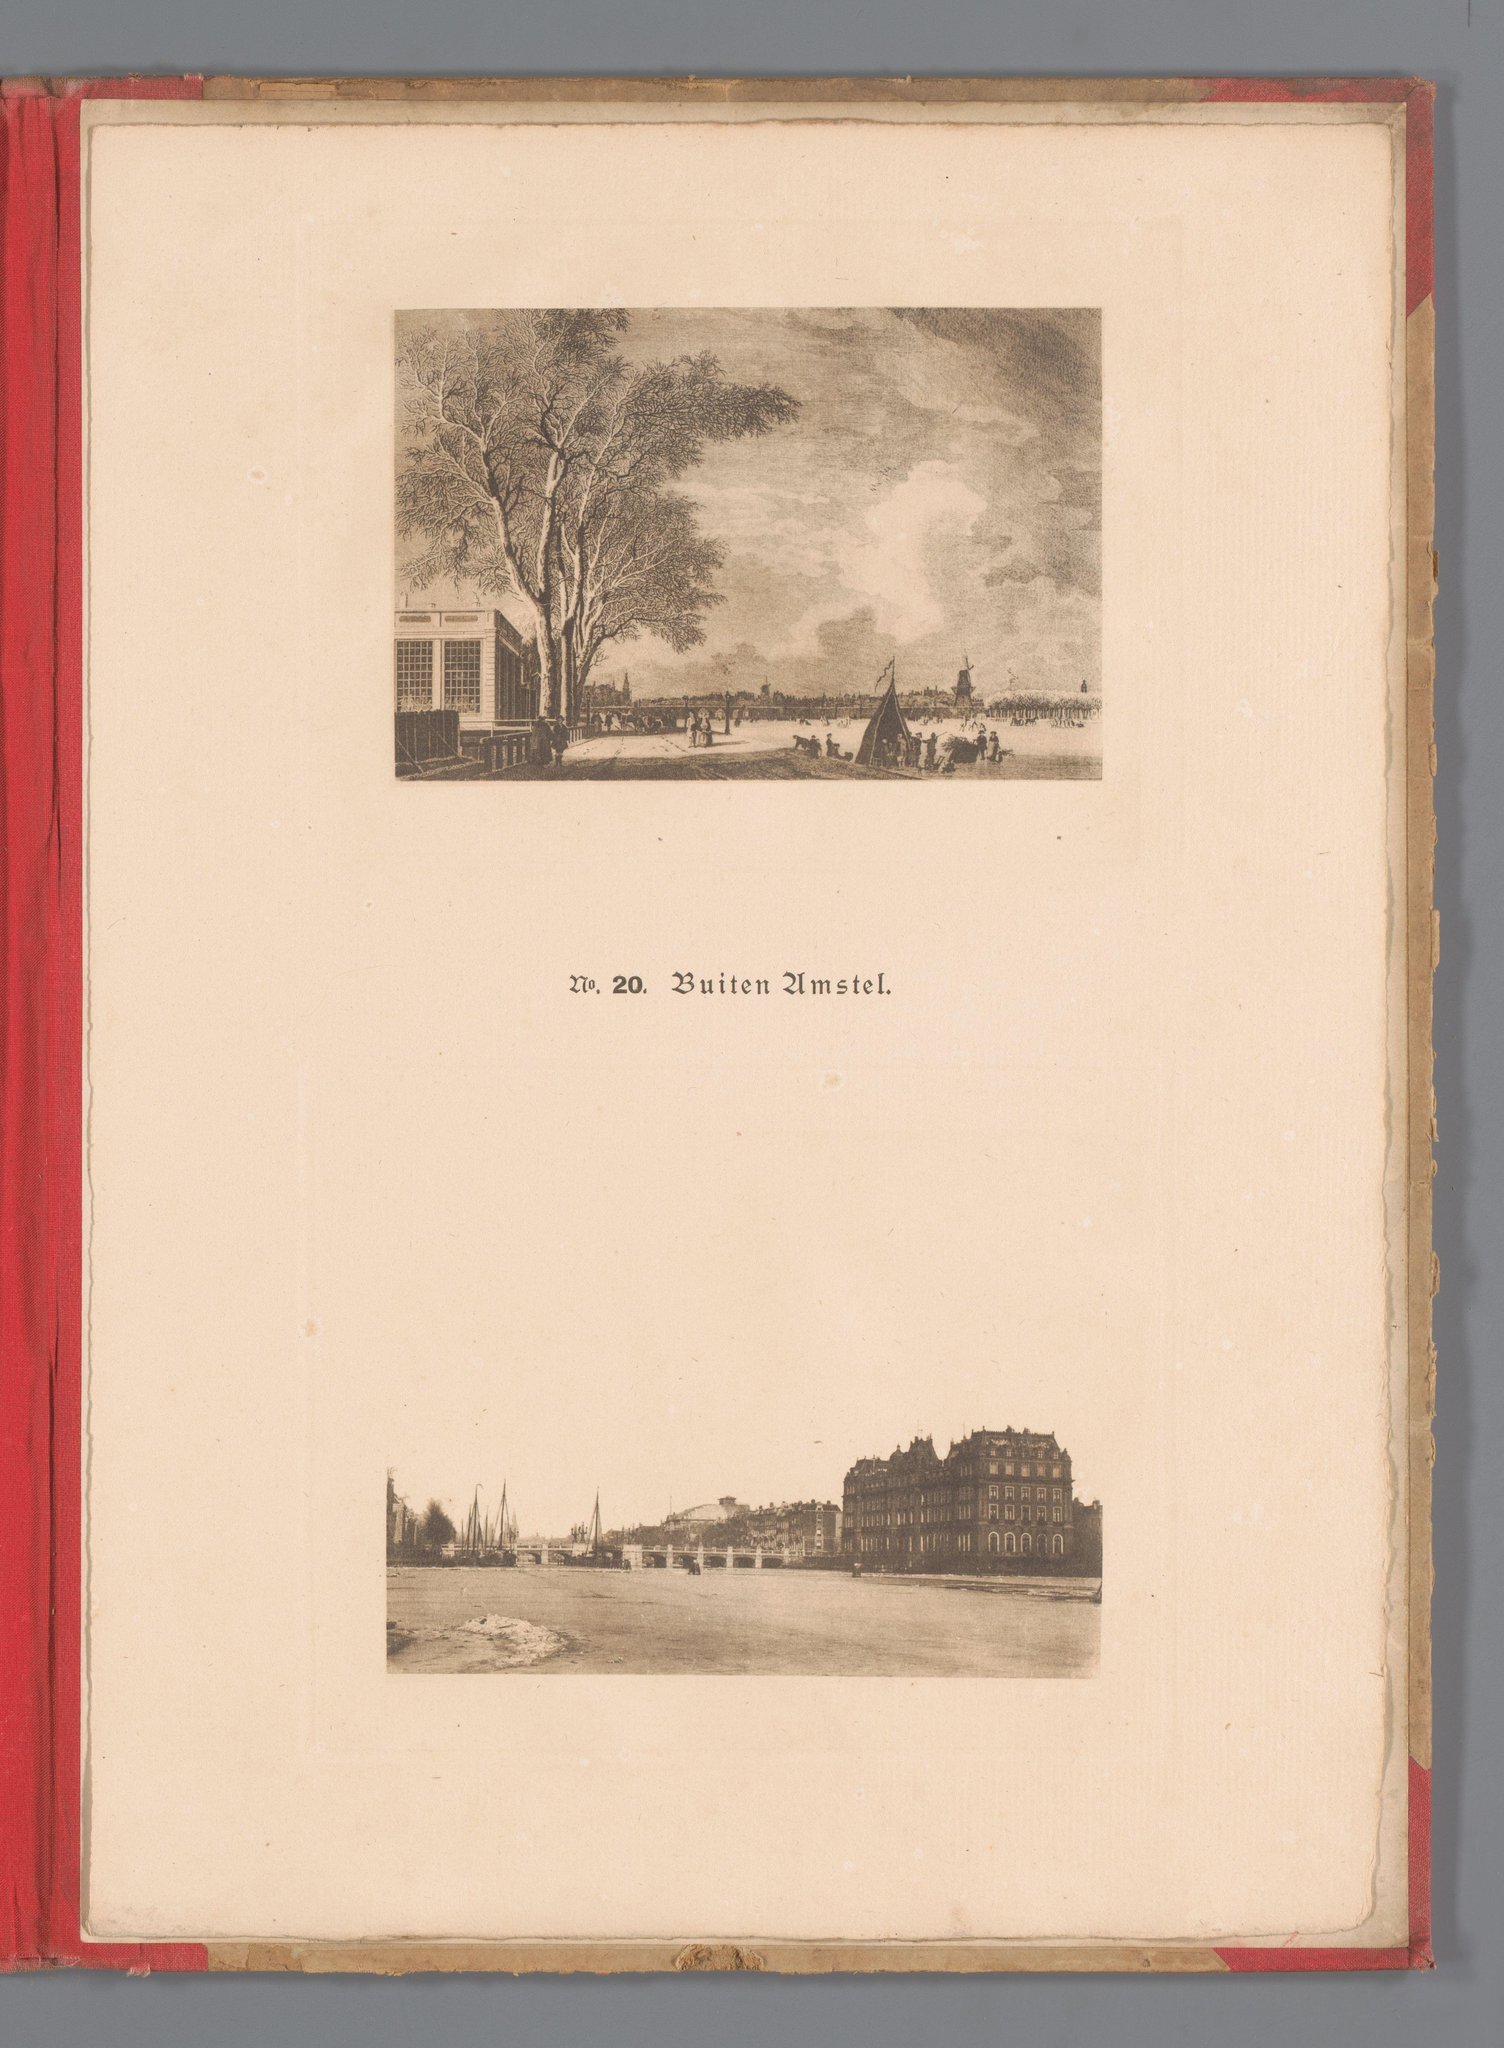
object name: photomechanical print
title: Twee gezichten op de bevroren Amstel te Amsterdam, waarvan één reproductie van een prent door Paulus van Liender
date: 1890-1900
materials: paper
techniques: photograph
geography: amsterdam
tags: winter landscape; landscape symbolizing winter (the four seasons of the year), skates (winter sports), hotel, hostelry, inn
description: Deze prenten maken deel uit van een album.